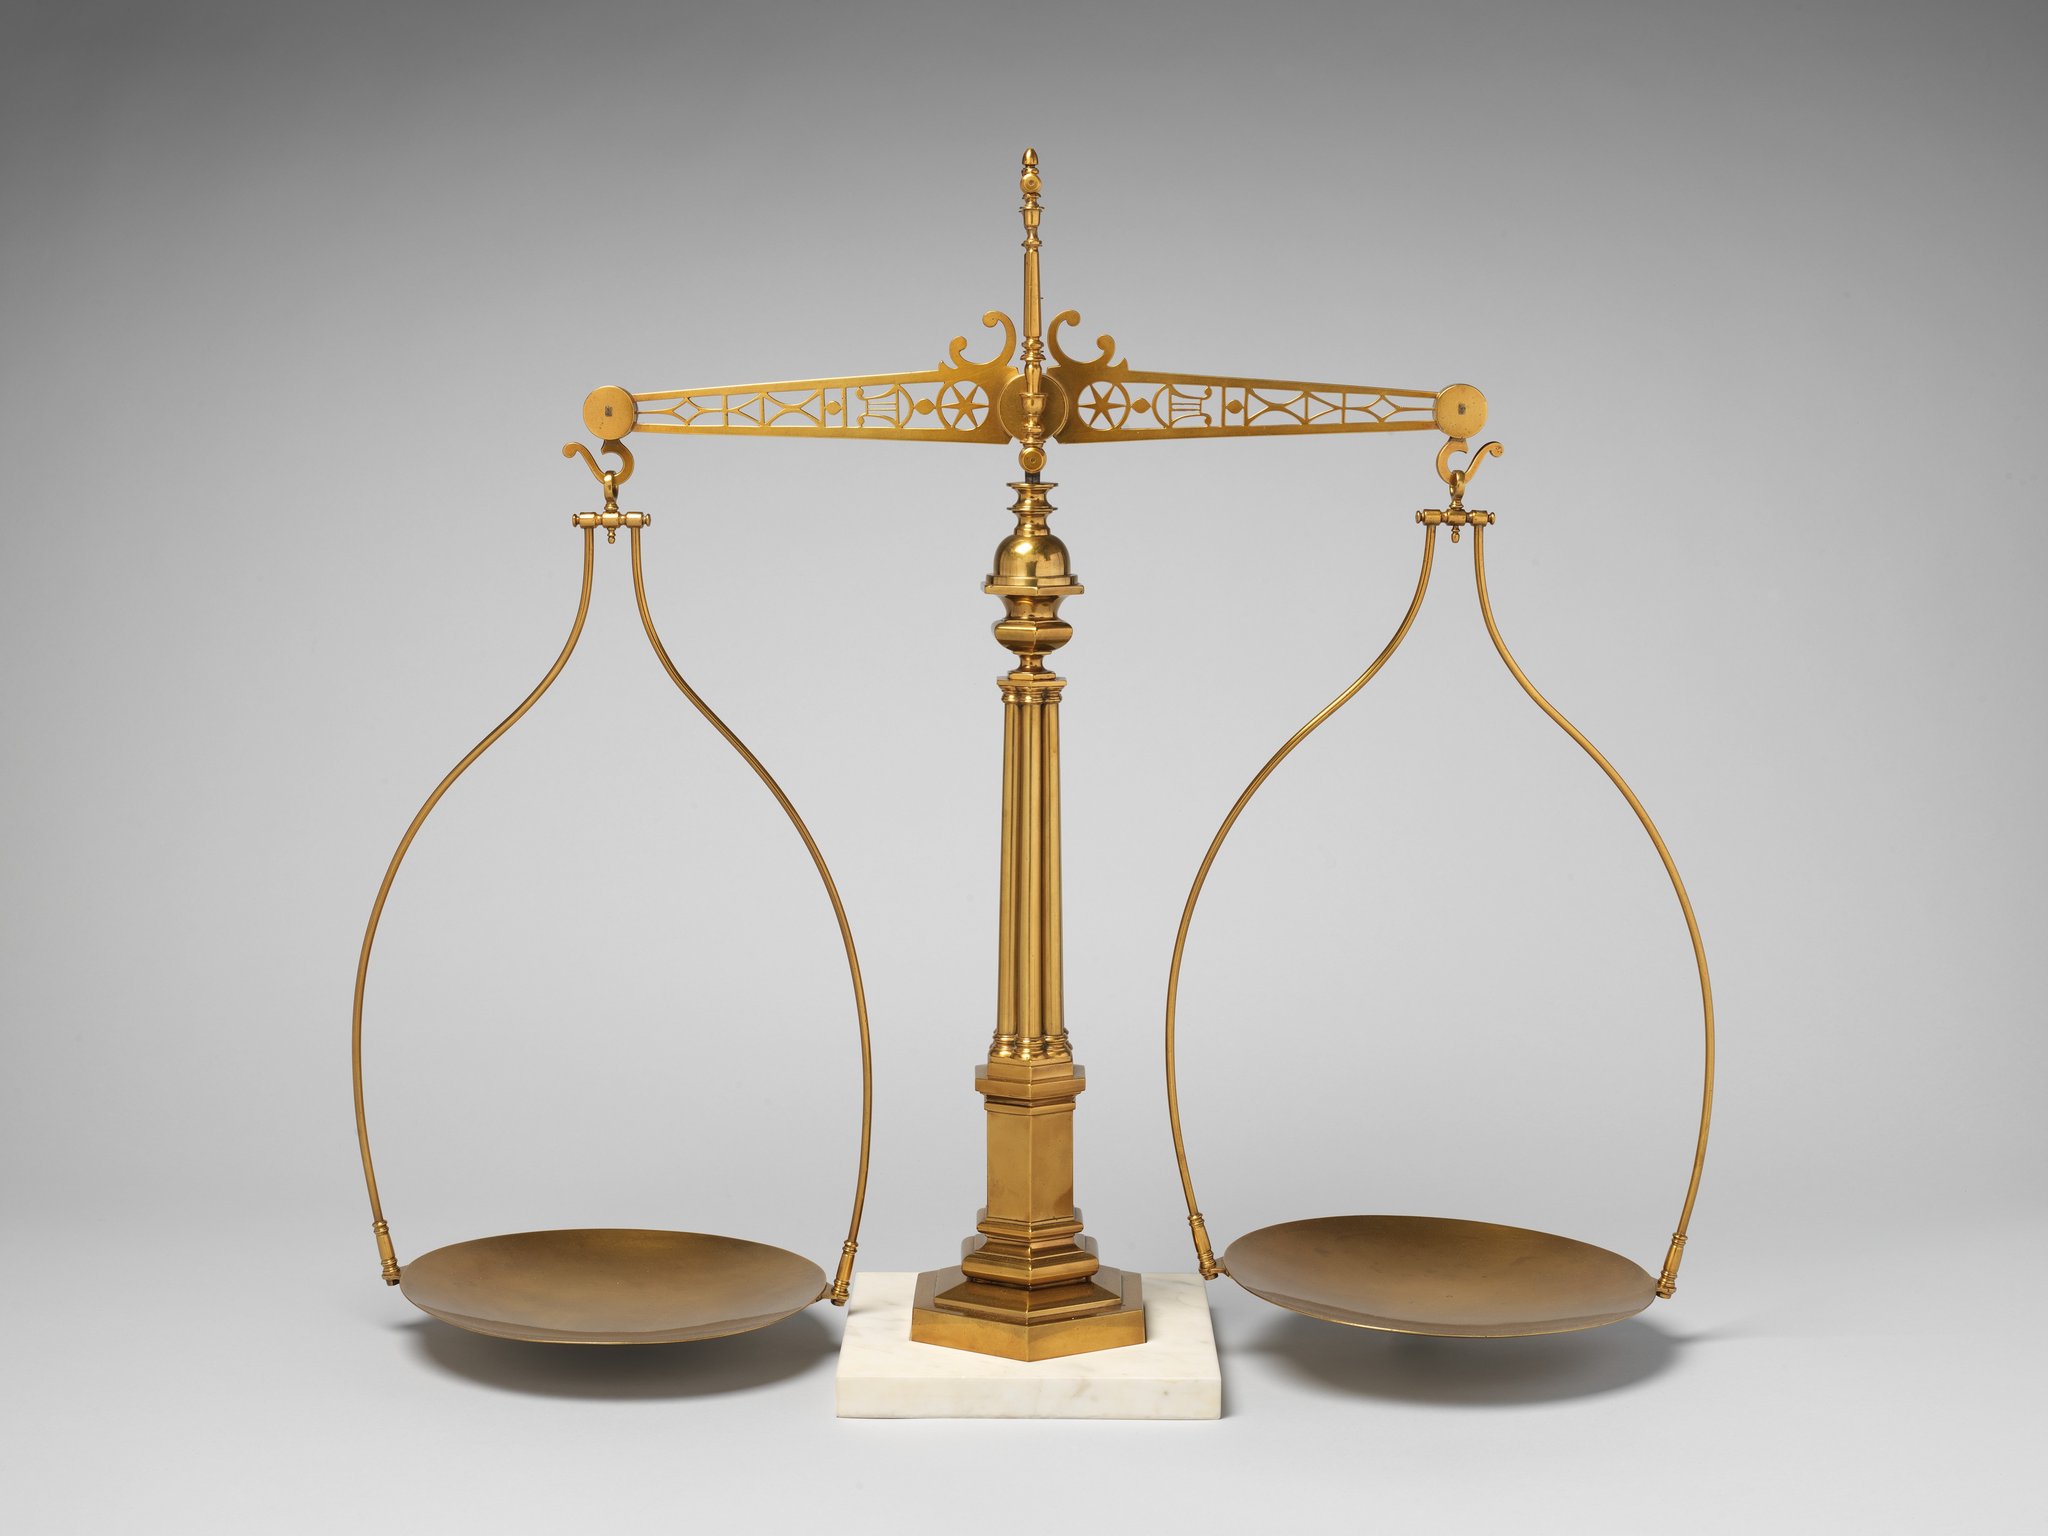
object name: scale balance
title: Balance scale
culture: american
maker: henry n. hooper and company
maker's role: maker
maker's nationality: american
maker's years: 1830-1868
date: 1845-1855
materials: brass, marble, steel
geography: united states